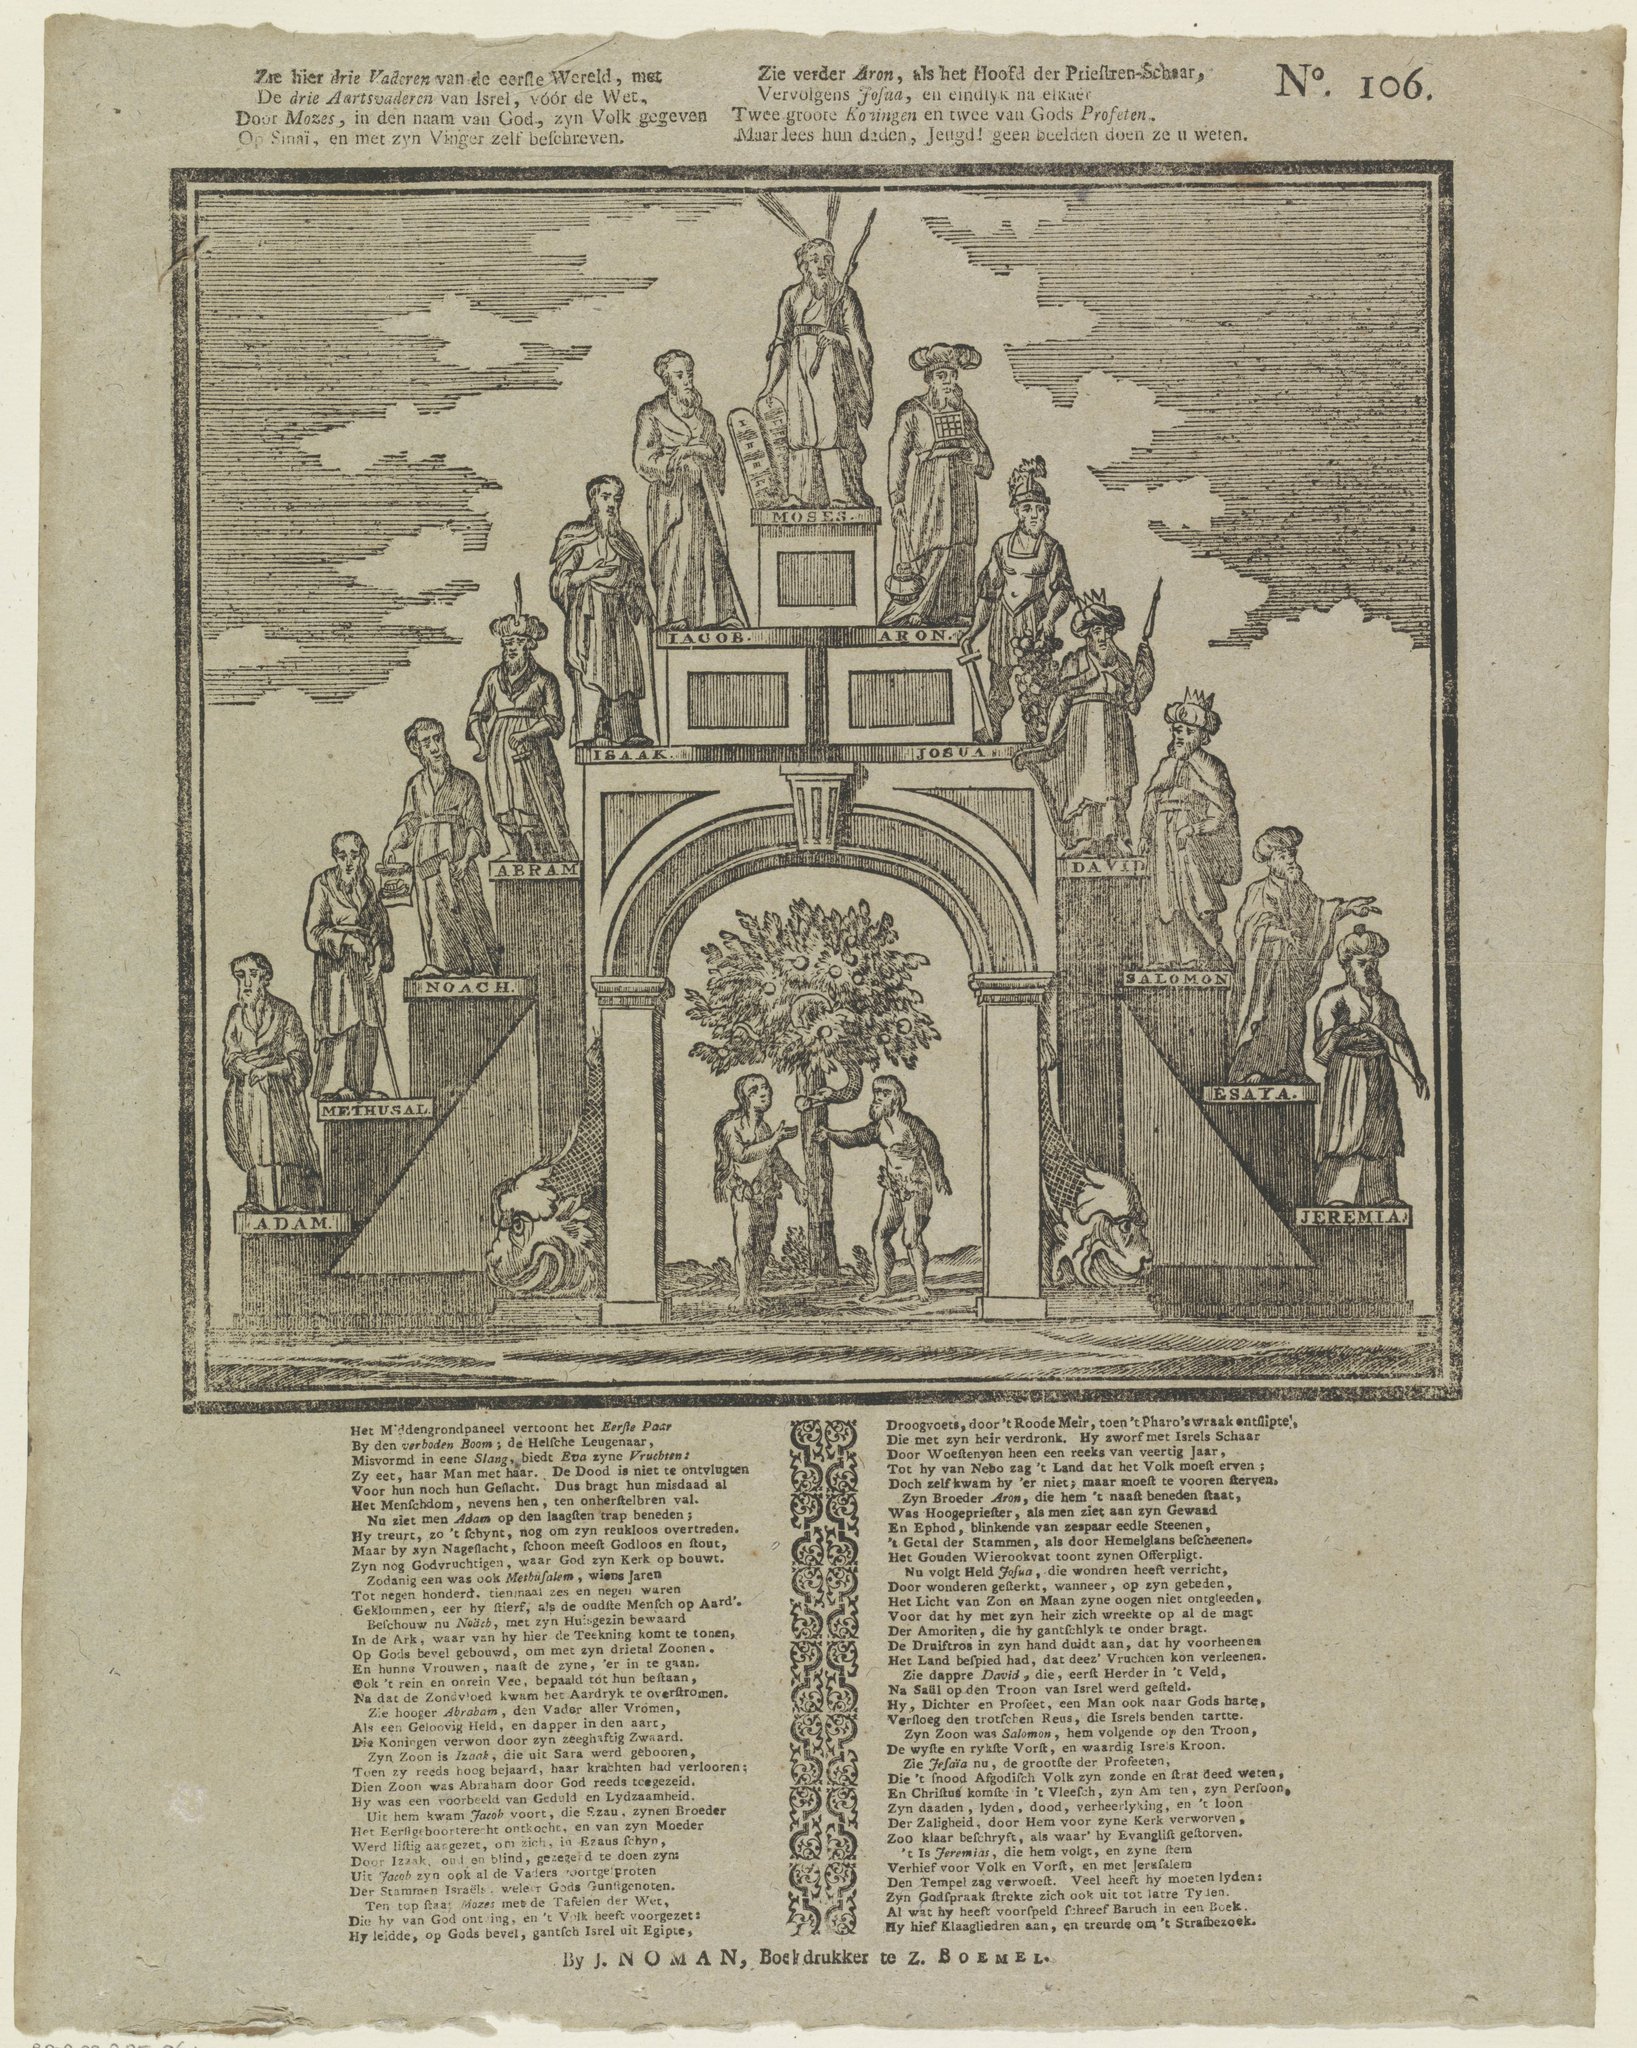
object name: print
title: Zie hier drie vaderen van de eerste wereld, met / De drie aartsvaderen van Isrel, vóór de wet [(...)]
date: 1806-1830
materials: paper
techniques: letterpress printing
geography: zaltbommel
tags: moses (not in biblical context); possible attributes: rays of light or horns on his head, rod, tables of the law - patron, intercessor ~ the old testament (not in biblical context), prophets, sibyls, evangelists, doctors of the church; persons ~ the bible (not in biblical context), the serpent tries to persuade eve to take some of the fruit (usually an apple), groups of prophets, usually holding books or scrolls (isaiah, jeremiah, ezekiel, daniel, hosea, joel, amos, obadiah, jonah, micah, nahum, habakkuk, zephaniah, haggai, zechariah, malachi)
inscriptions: collector's mark: Lugt 2760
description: Blad met een grote voorstelling van een trap met dertien treden. Op de treden staan Mozes, aartsvaderen, koningen en profeten. In de boog onder de trap de verzoeking van Adam en Eva bij de boom der kennis van goed en kwaad. Onder de afbeelding een vers in twee kolommen. Genummerd rechtsboven: No. 106.